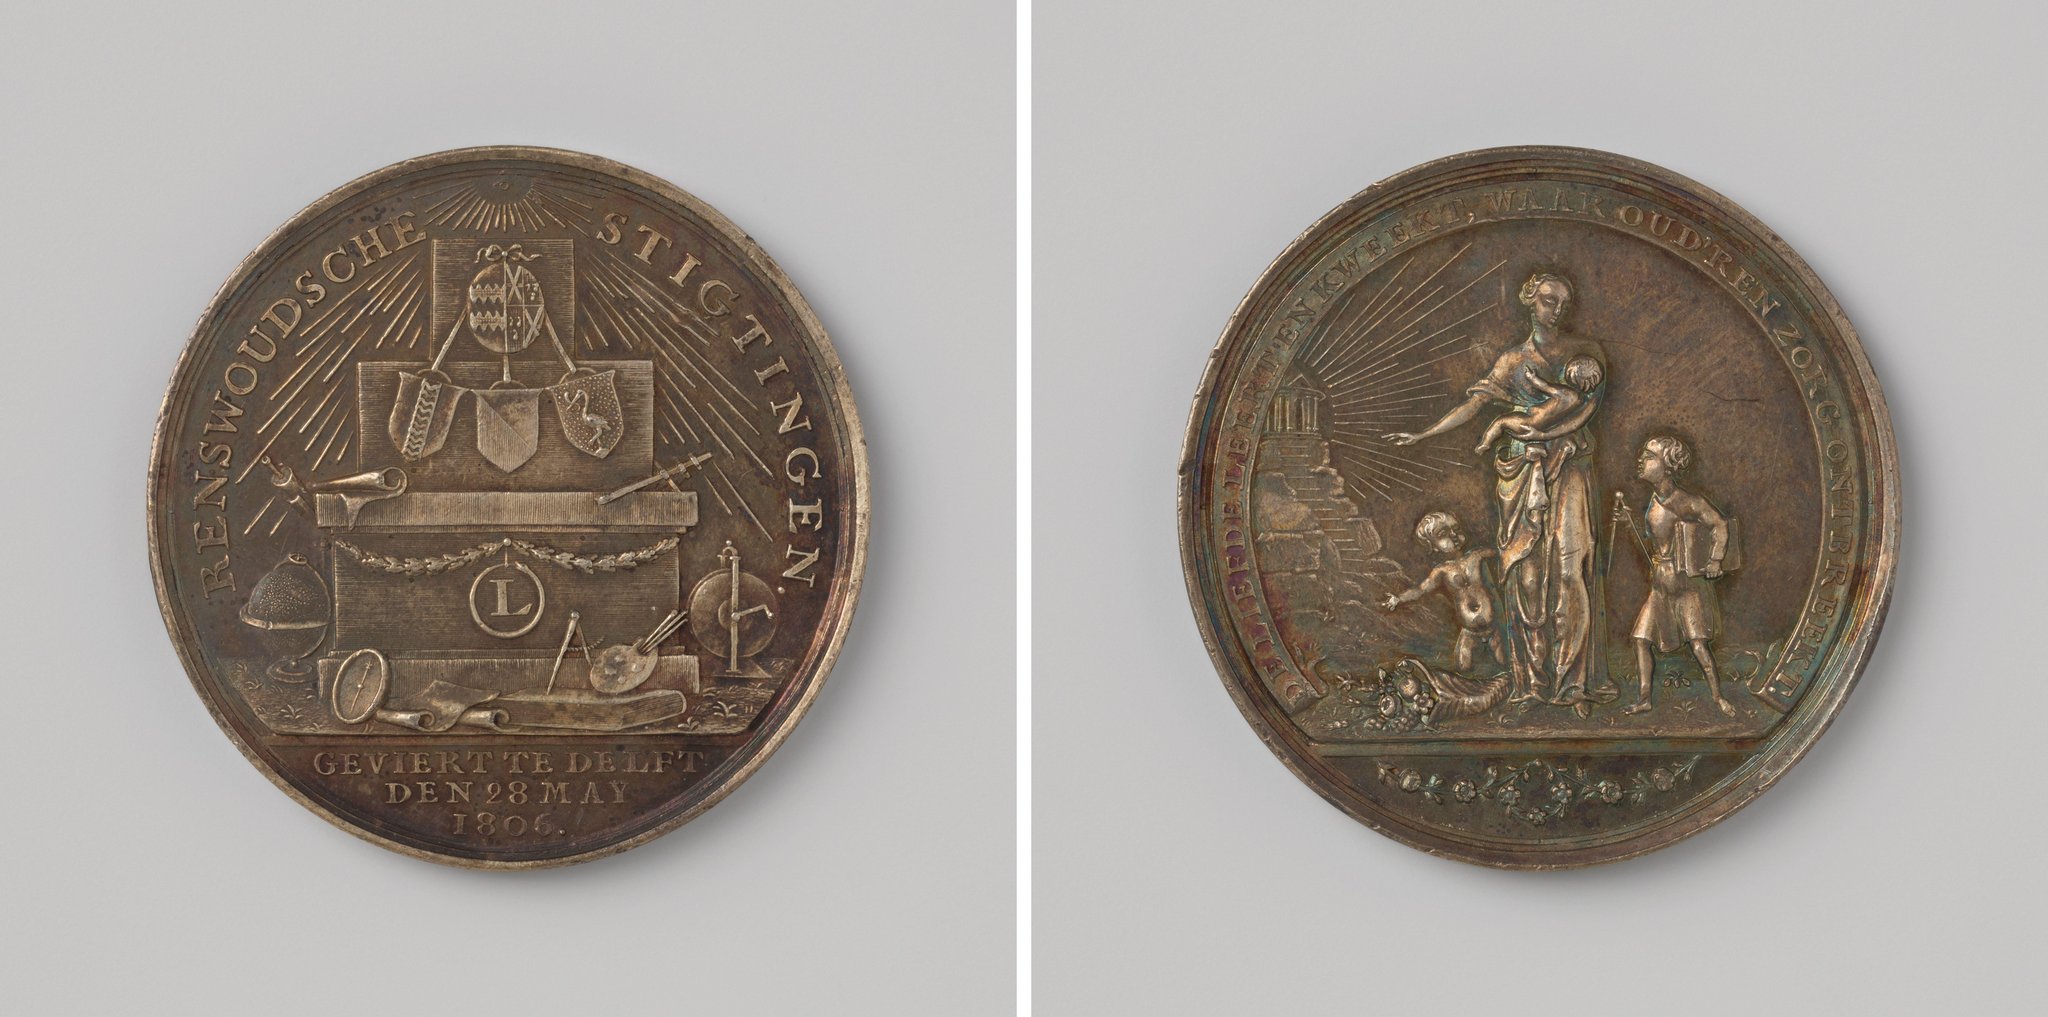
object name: history medal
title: Vijftigjarig bestaan van de Stichtingen van de weduwe Reede van Renswoude te Utrecht, 's-Gravenhage en Delft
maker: david van der kellen (1764-1825)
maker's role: die cutter, draughtsman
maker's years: 1764-1825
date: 1806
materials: silver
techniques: gilding, striking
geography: amsterdam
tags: the hague, delft, utrecht